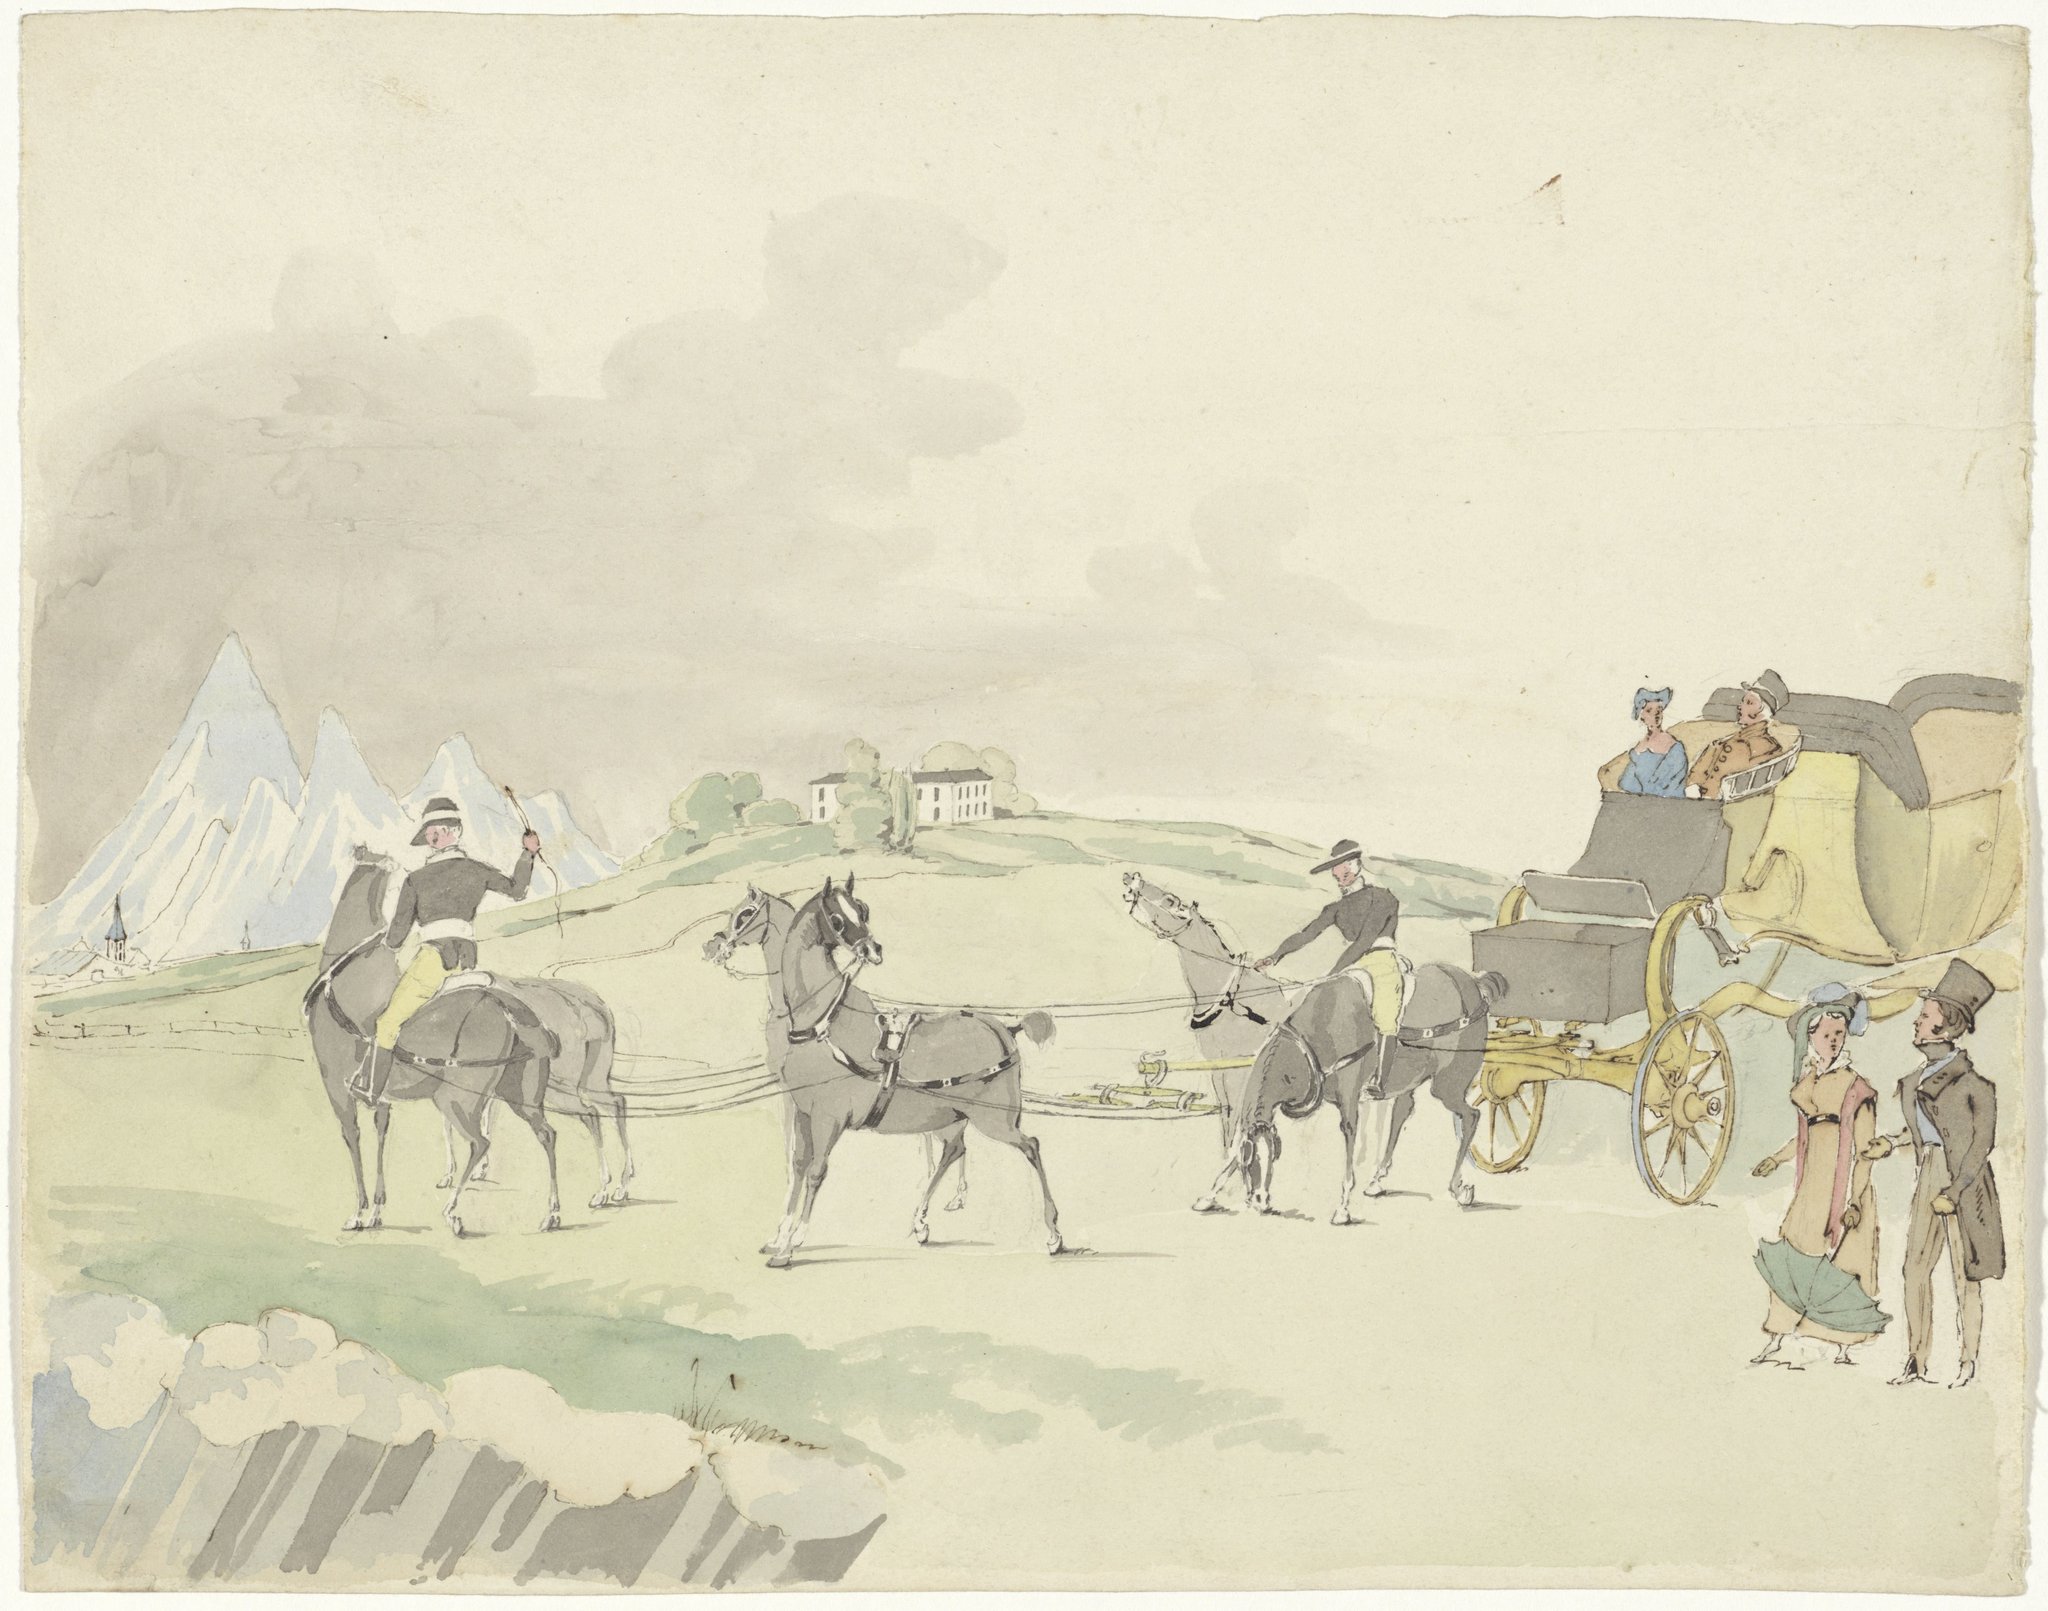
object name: watercolor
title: Reiskoets in een berglandschap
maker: pieter van loon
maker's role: draughtsman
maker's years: 1801-1873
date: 1811-1873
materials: ink, paper, pencil, watercolor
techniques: brush, pen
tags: four-wheeled vehicle drawn by more than three animals (6)